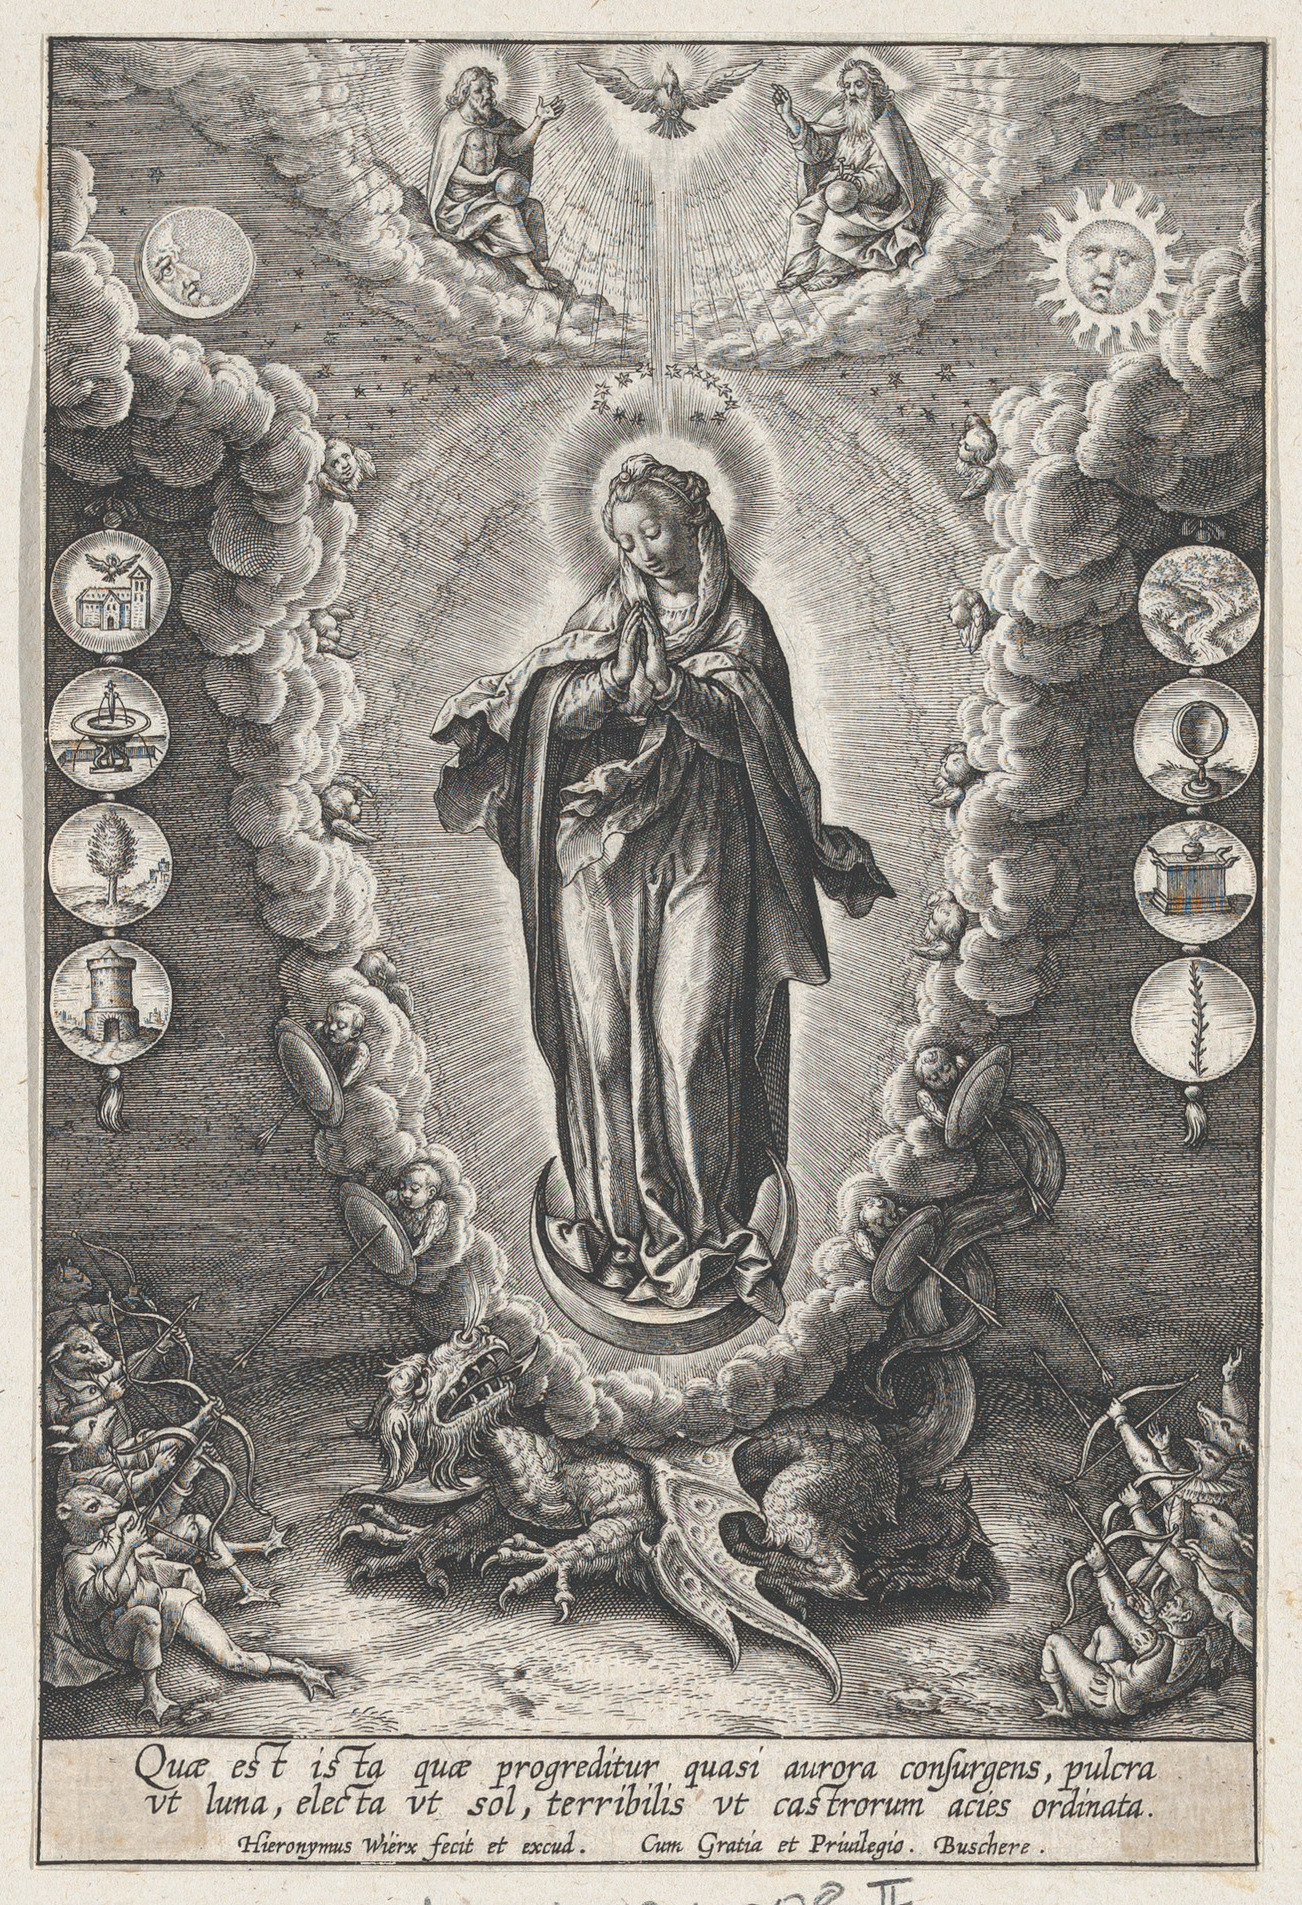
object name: print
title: The Virgin with the Symbols of the Lauretanian Litany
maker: hieronymus wierix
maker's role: artist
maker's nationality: netherlandish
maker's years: 1553-1619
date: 1573-1619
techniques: engraving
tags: virgin mary